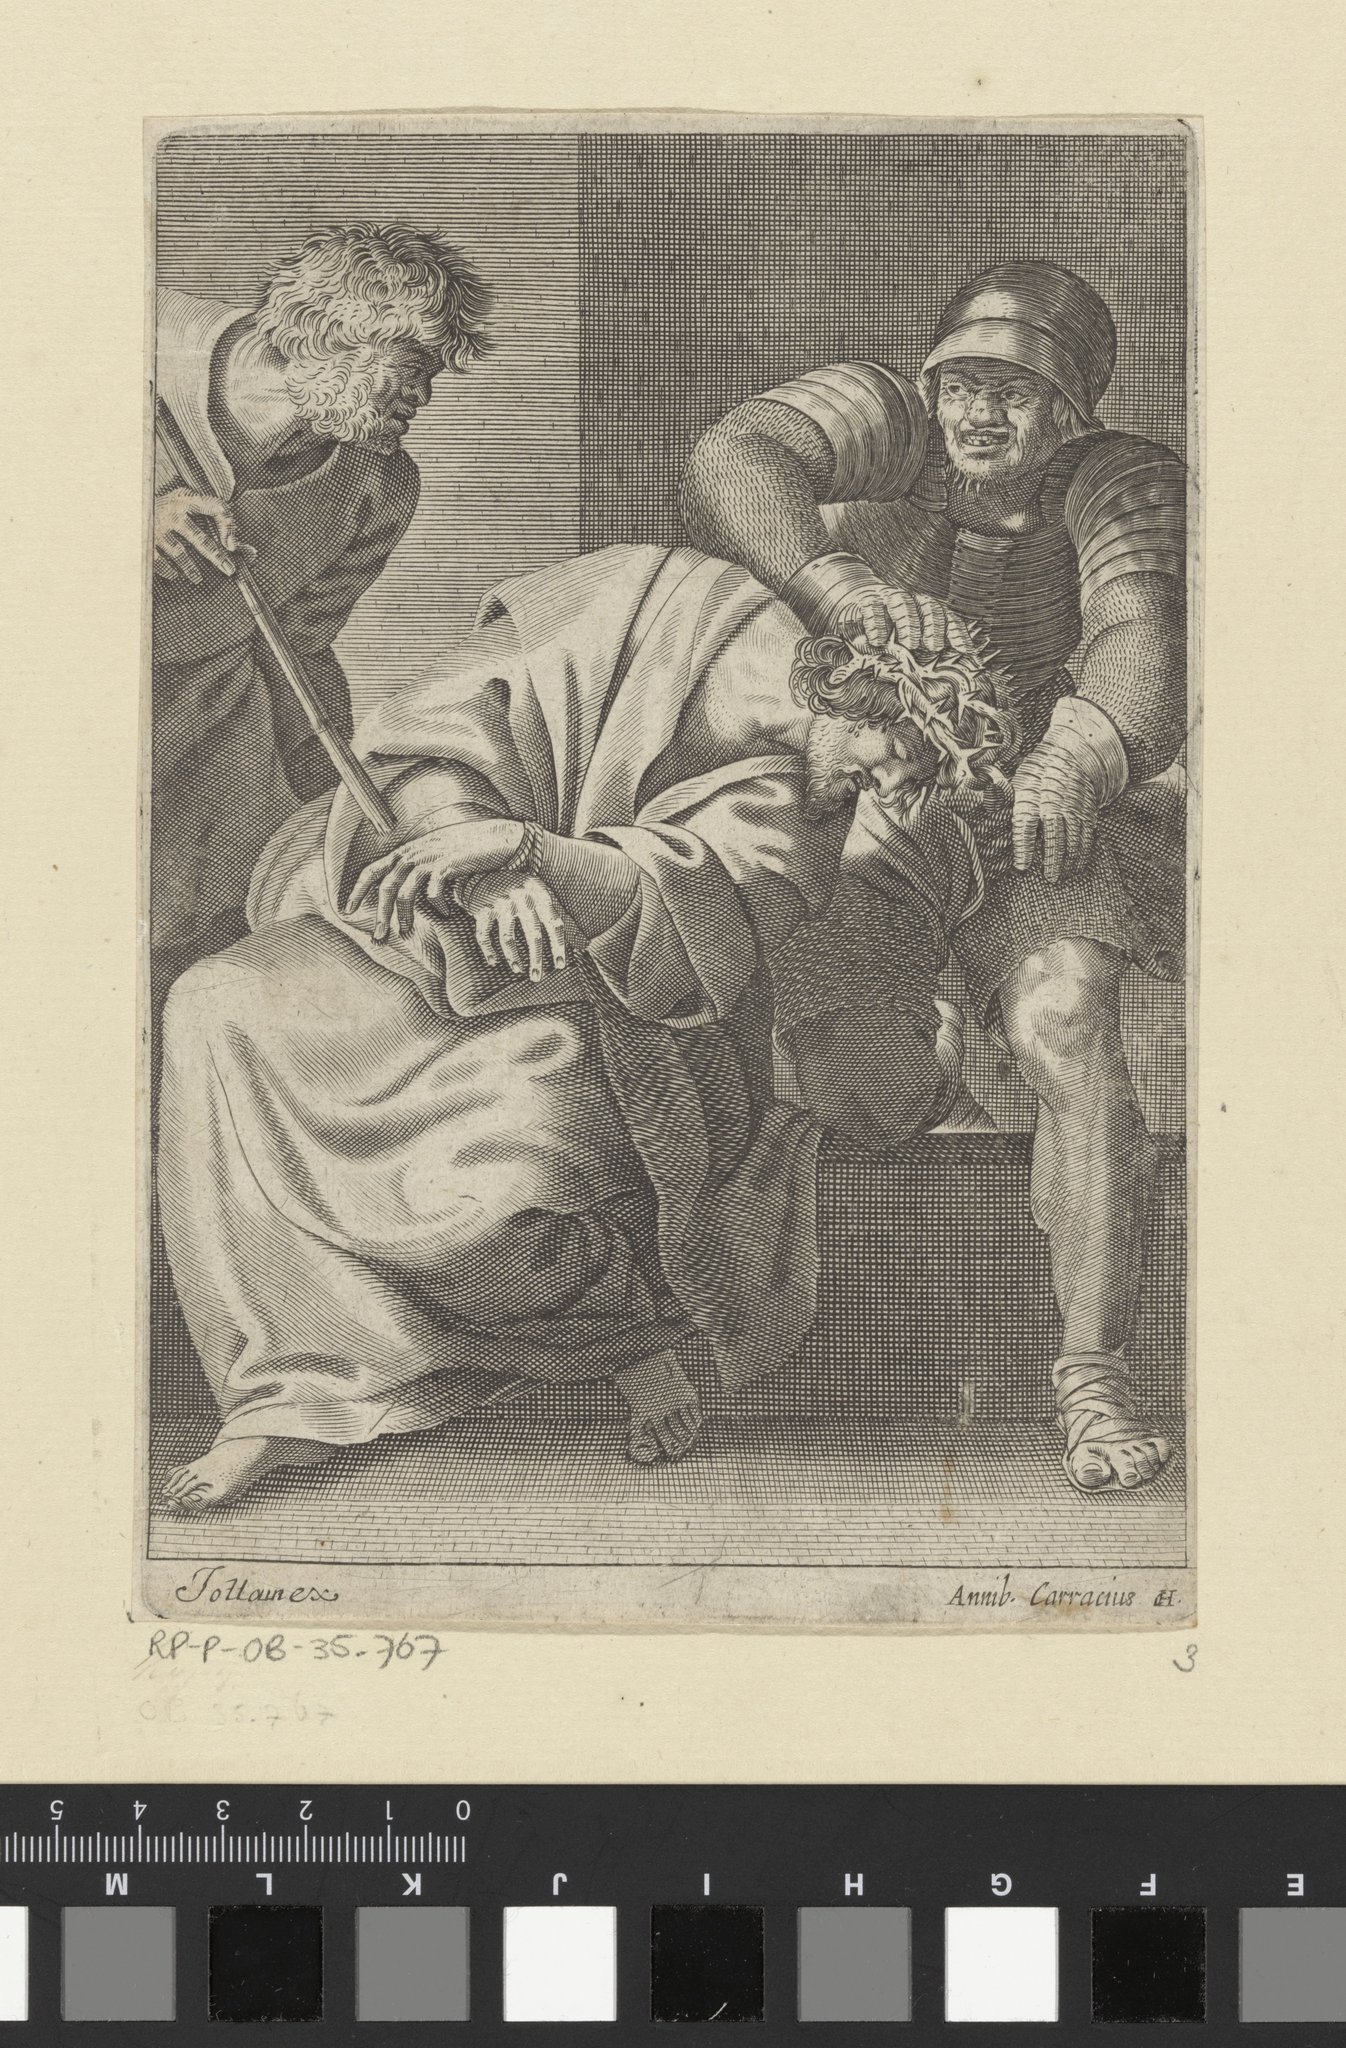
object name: print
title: Doornenkroning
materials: paper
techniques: engraving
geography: italy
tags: the crowning with thorns: soldiers with sticks place a thorny crown on christ's head and give him a reed (matthew 27:27-31; mark 15:16-20; john 19:2-3)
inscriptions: collector's mark: Lugt 240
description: Een soldaat plaatst de doornenkroon op het hoofd van Christus. Een andere man geeft Chritus een staf van riet.